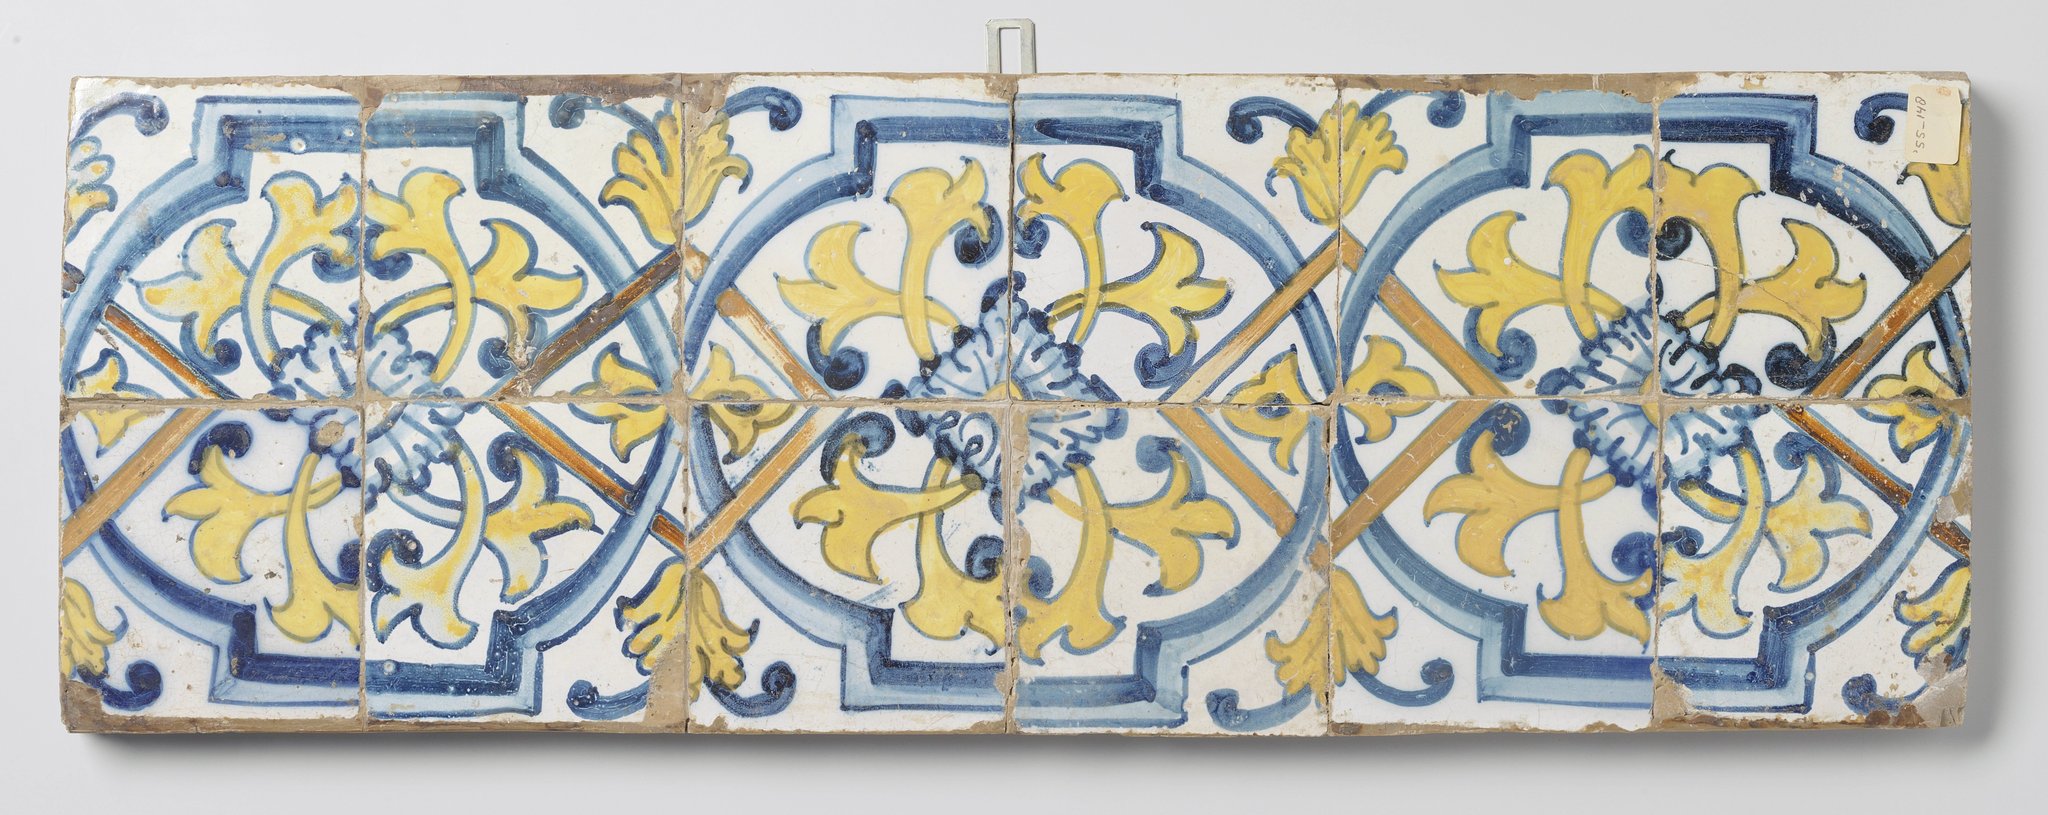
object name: tile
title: Veld van twaalf veelkleurige tegels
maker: Anonymous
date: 1600-1625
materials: earthenware, glaze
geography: portugal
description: Veld van twaalf tegels (2 x 6) veelkleurig (blauw, geel en bruin) beschilderd met moresken en een rozet binnen een ovaal.